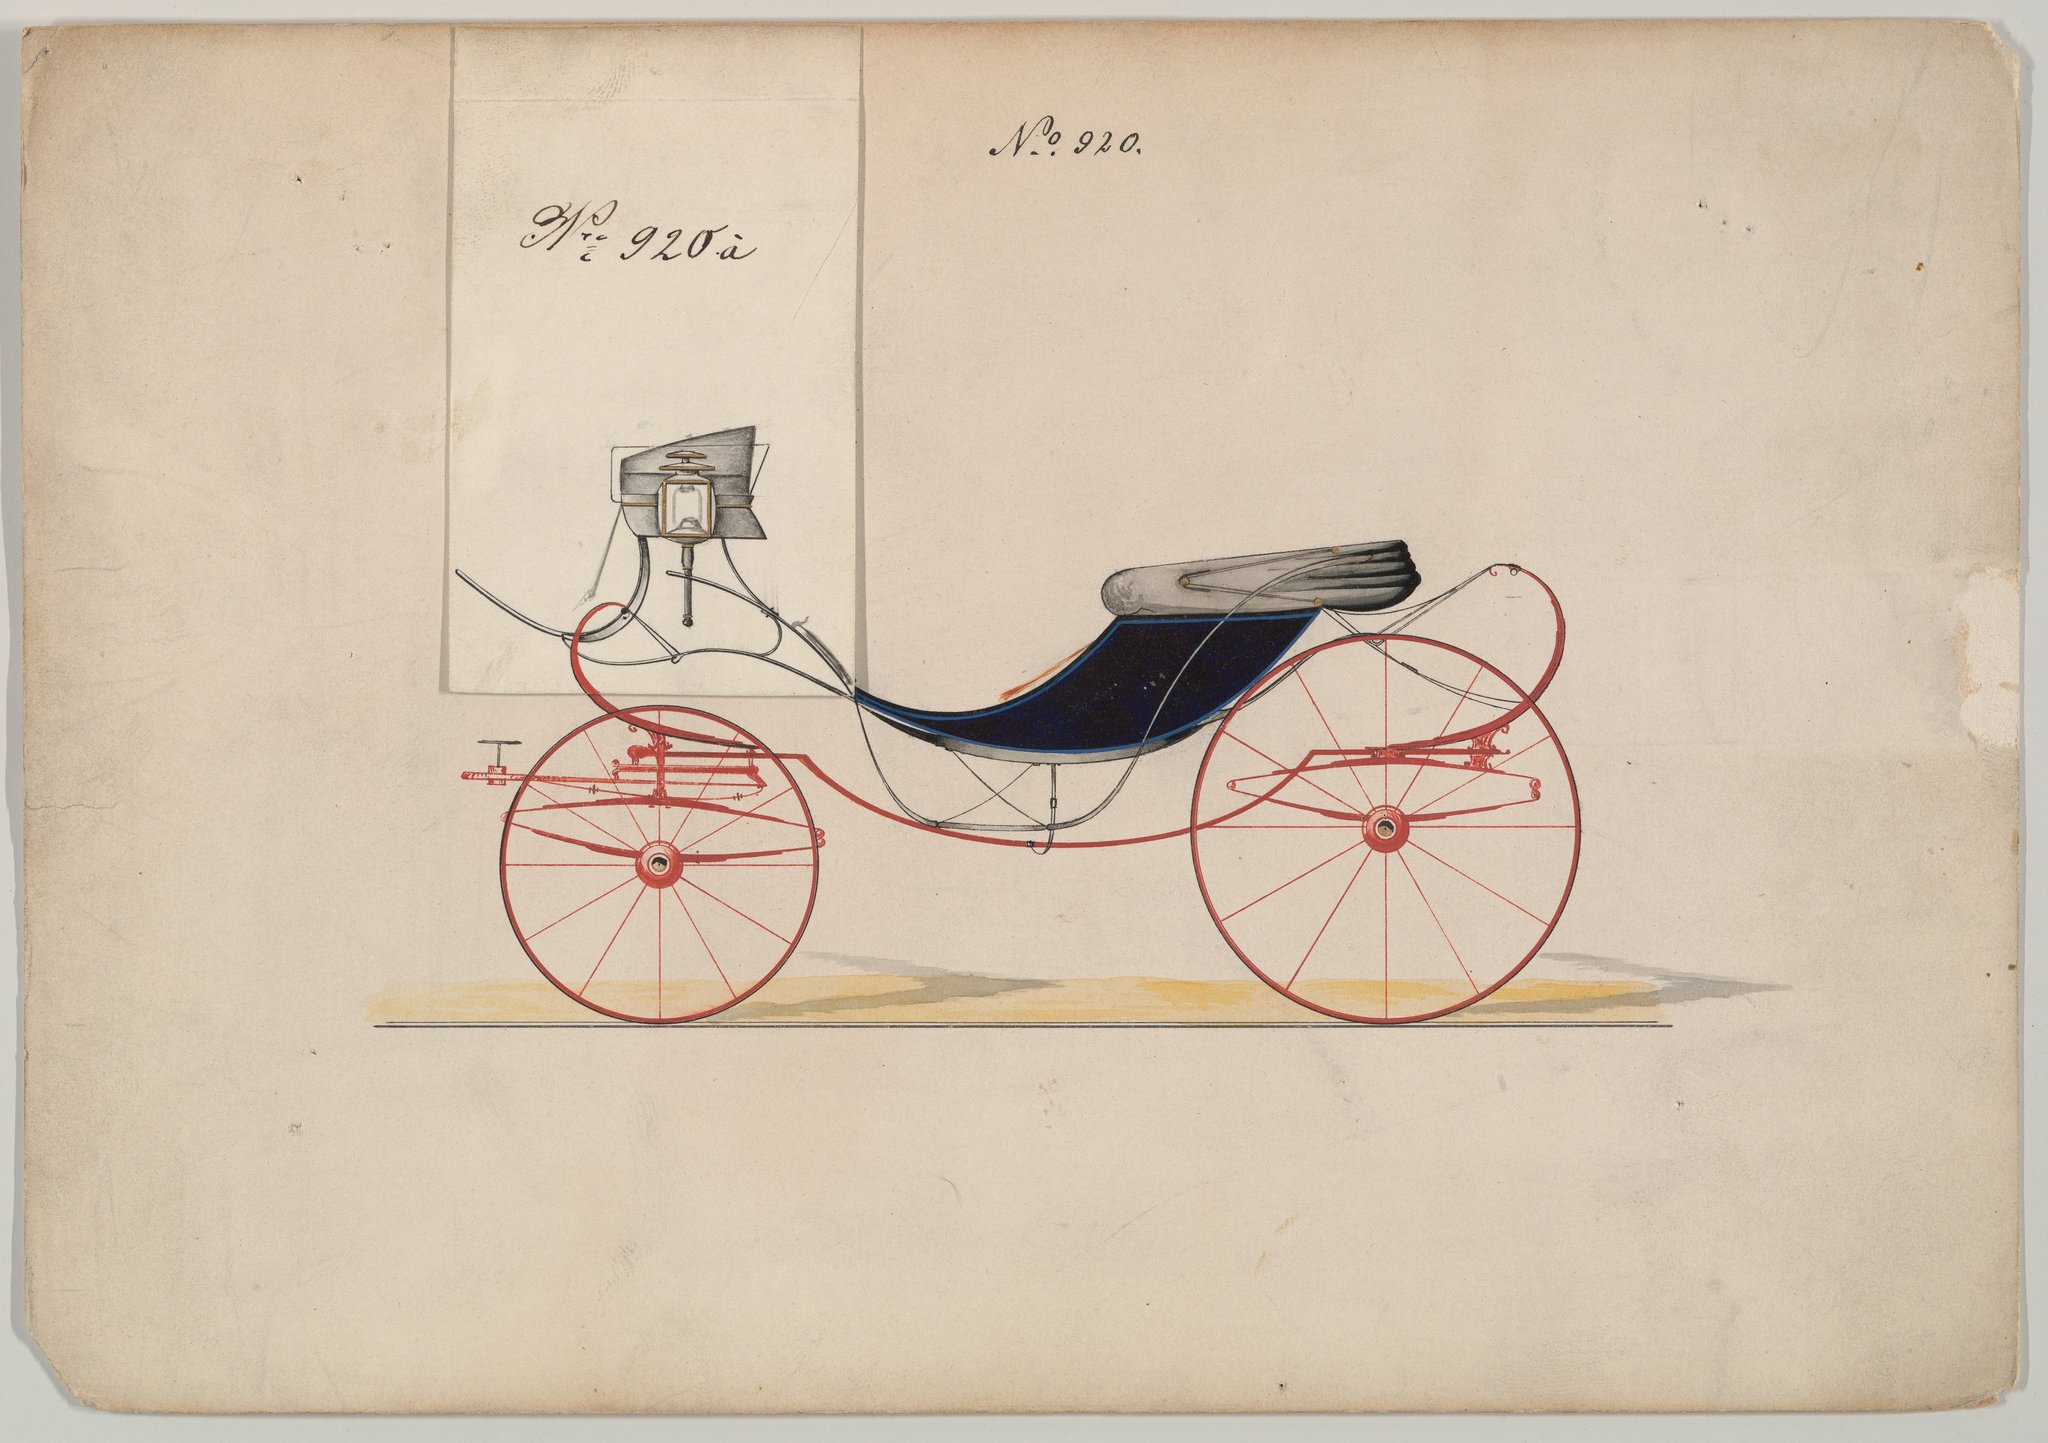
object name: drawing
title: Eight Spring Victoria #920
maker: brewster & co.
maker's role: manufacturer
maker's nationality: american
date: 1850-1874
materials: gouache, gum arabic, ink, watercolor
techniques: pen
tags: carriages